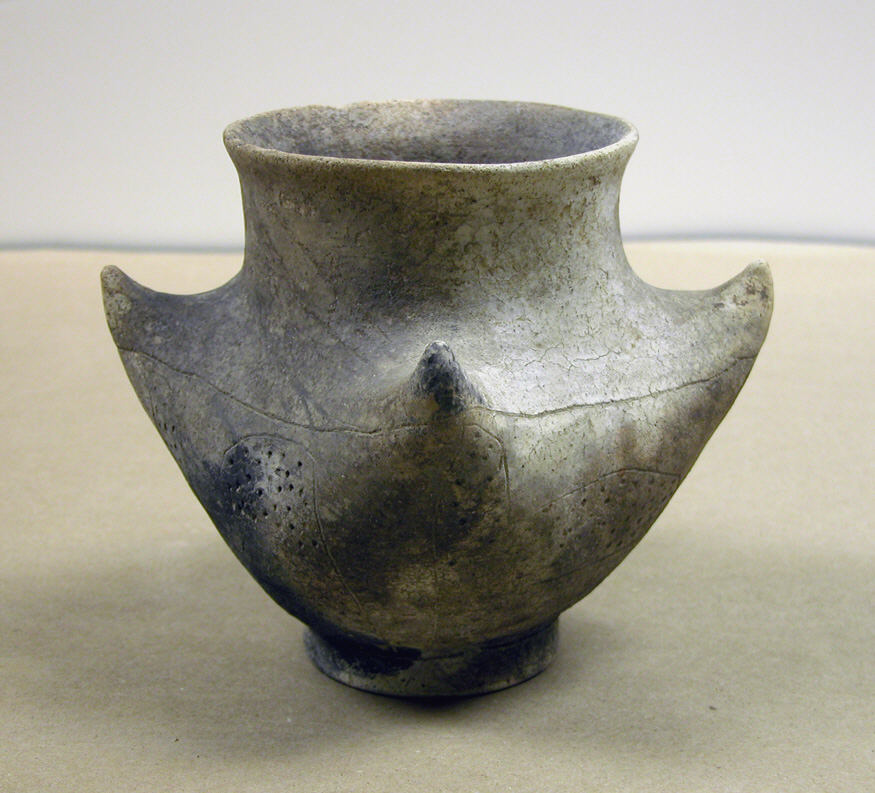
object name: vessel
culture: vietnamese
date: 500 BCE-300 CE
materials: ceramic